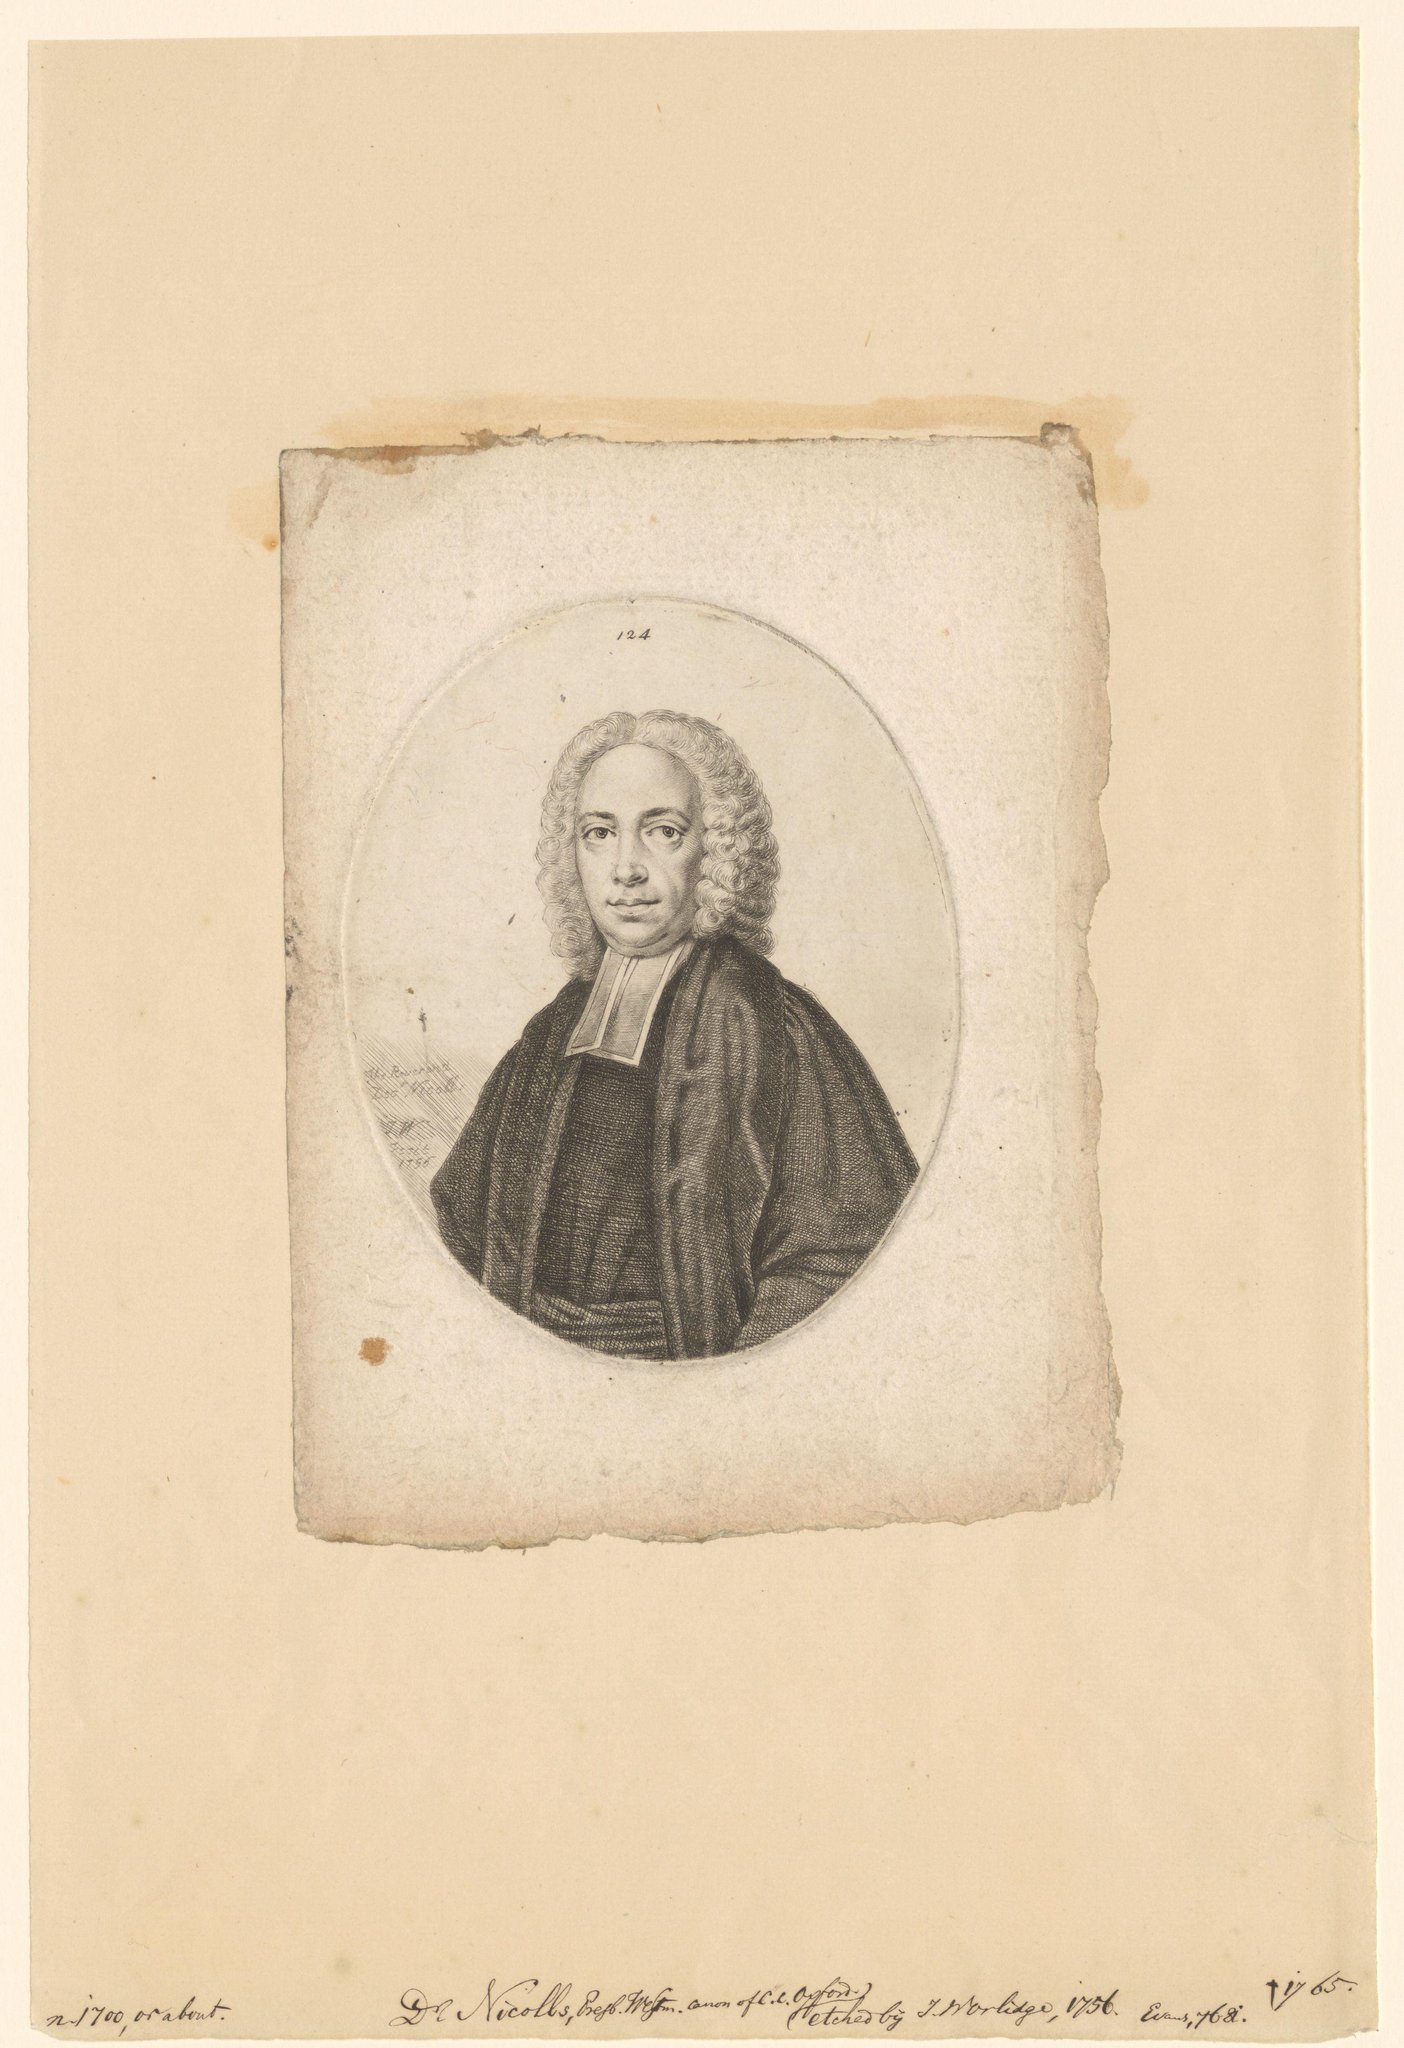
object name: print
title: Portret van John Nicoll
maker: thomas worlidge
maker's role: print maker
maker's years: 1700-1766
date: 1756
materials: paper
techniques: drypoint, etching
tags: historical person (...) - historical person (...) portrayed alone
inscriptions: collector's mark: Lugt 2228, inscription: ‘Dr. Nicolls 1756 etched by T. Worlidge’